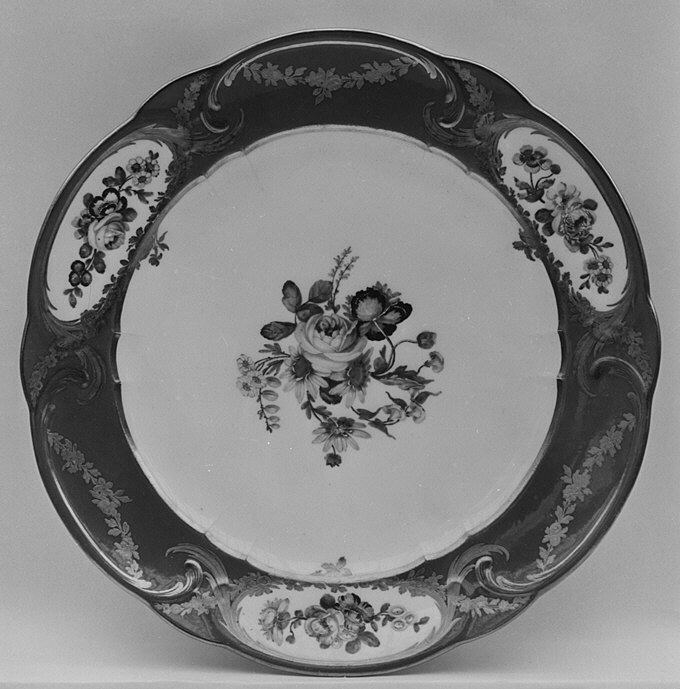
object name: plate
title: Plate (Assiette à palmes) (1 of 102) (part of a service)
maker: sèvres manufactory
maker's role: manufactory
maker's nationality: french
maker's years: 1740-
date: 1772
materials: soft paste porcelain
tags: flowers